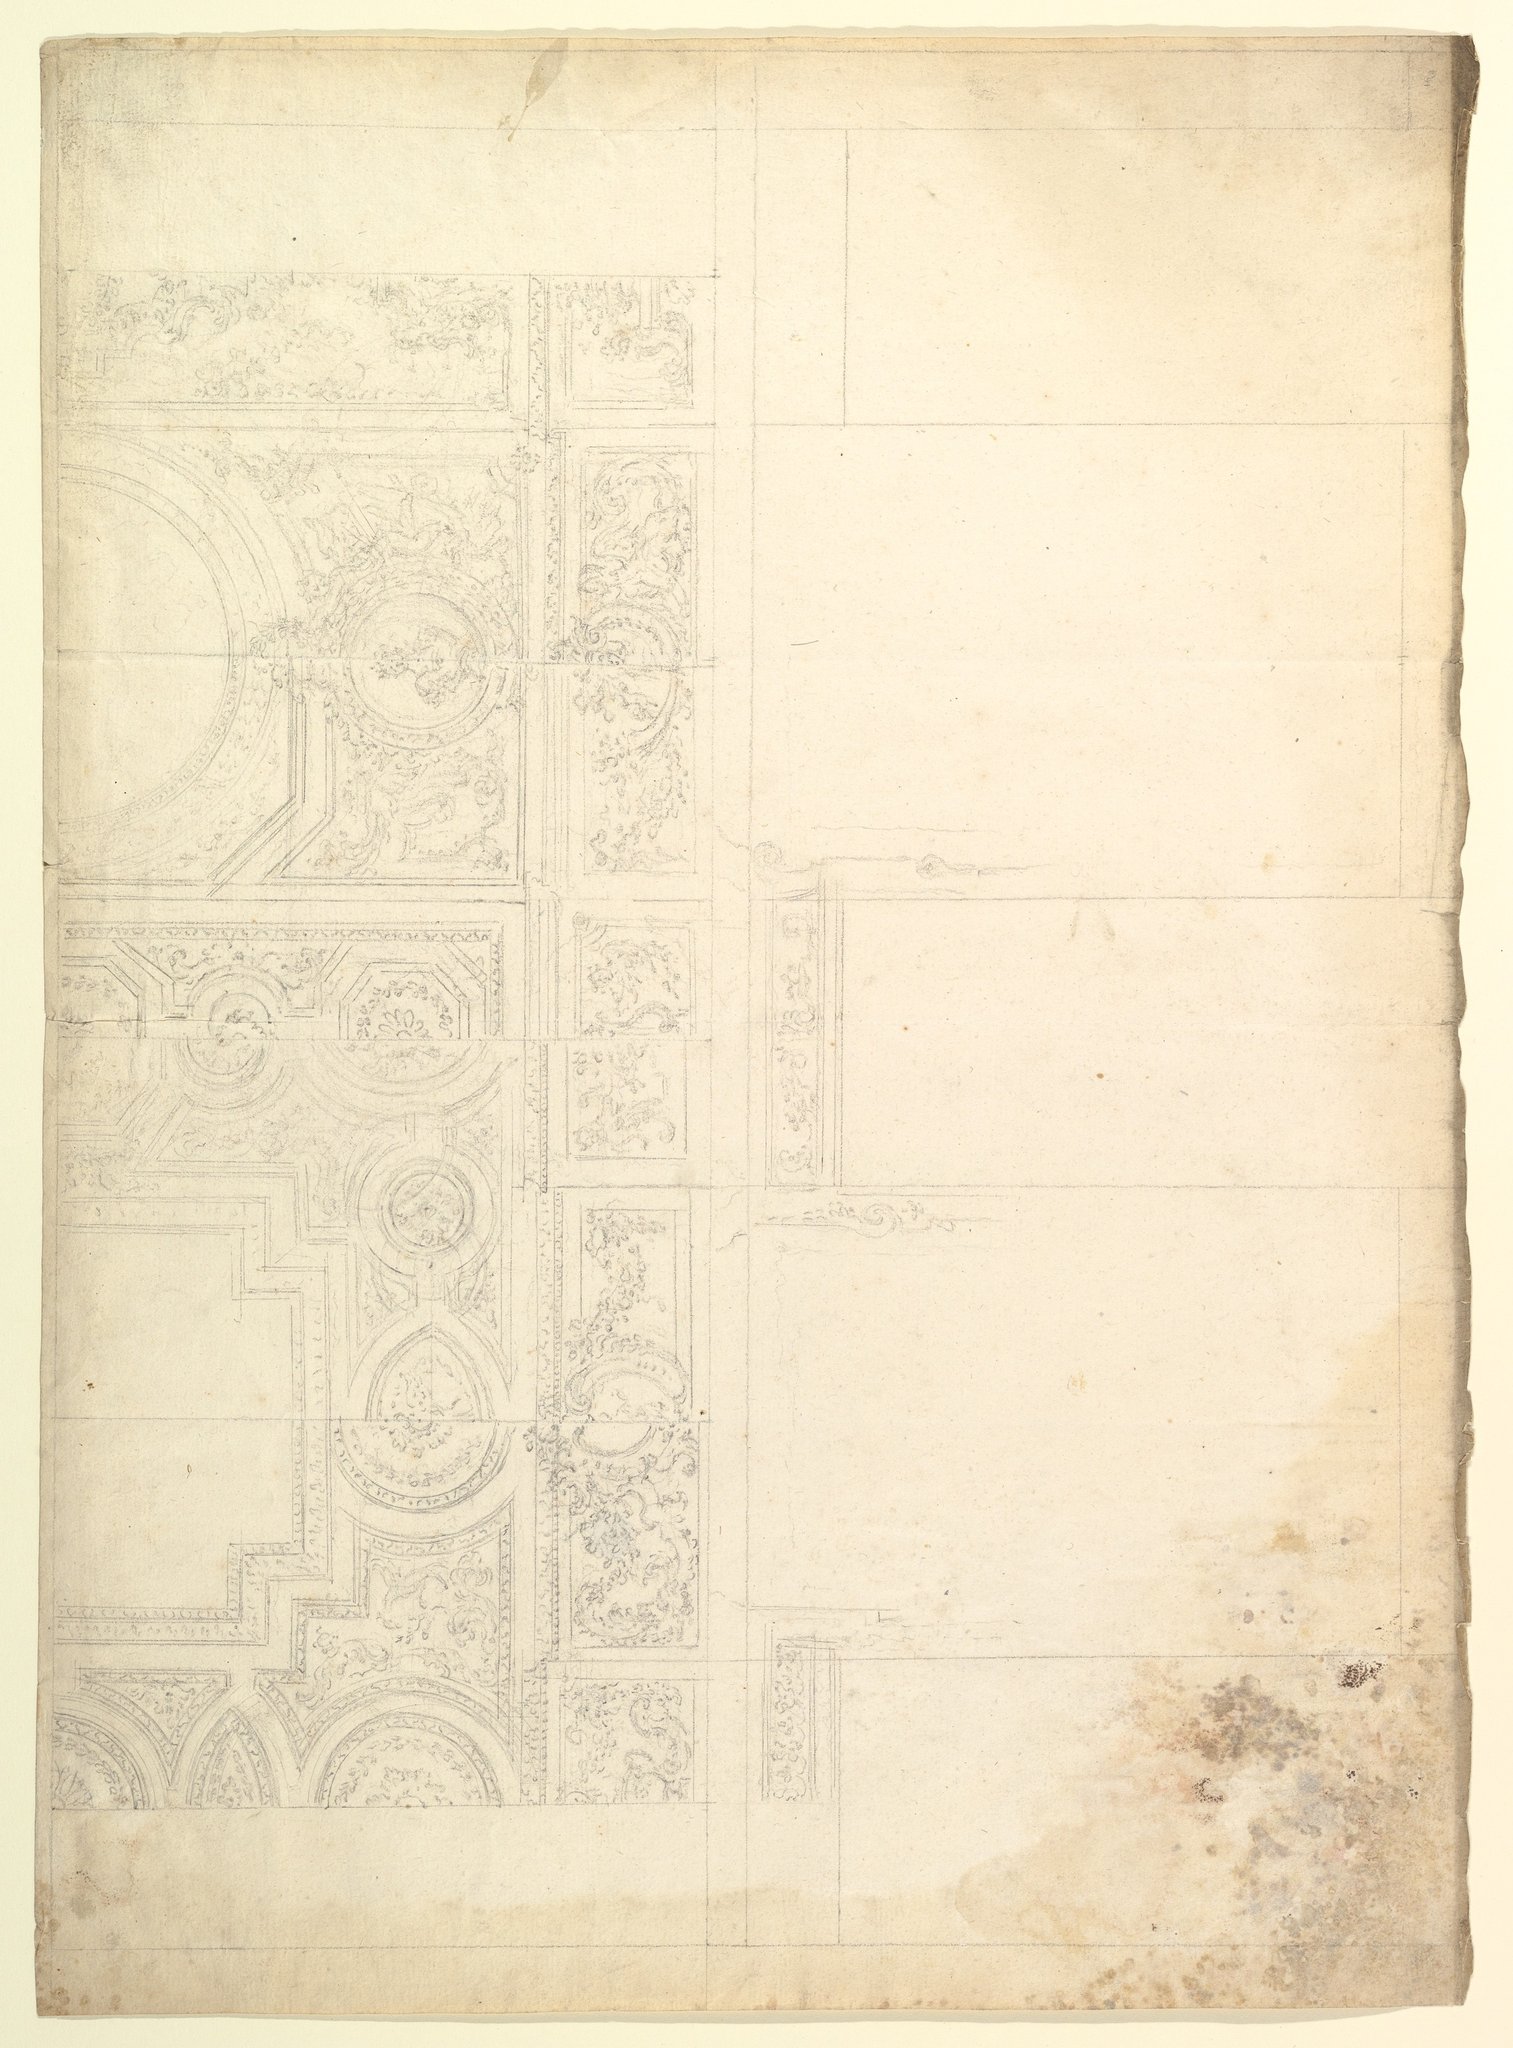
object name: drawing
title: Design for Ceiling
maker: anonymous, italian, piedmontese, 18th century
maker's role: artist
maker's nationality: italian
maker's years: 1700-1800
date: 1700-1780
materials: graphite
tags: architecture,ceilings